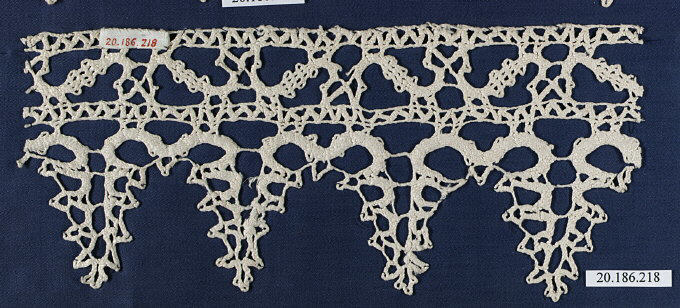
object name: edging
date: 1601-1700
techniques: lace